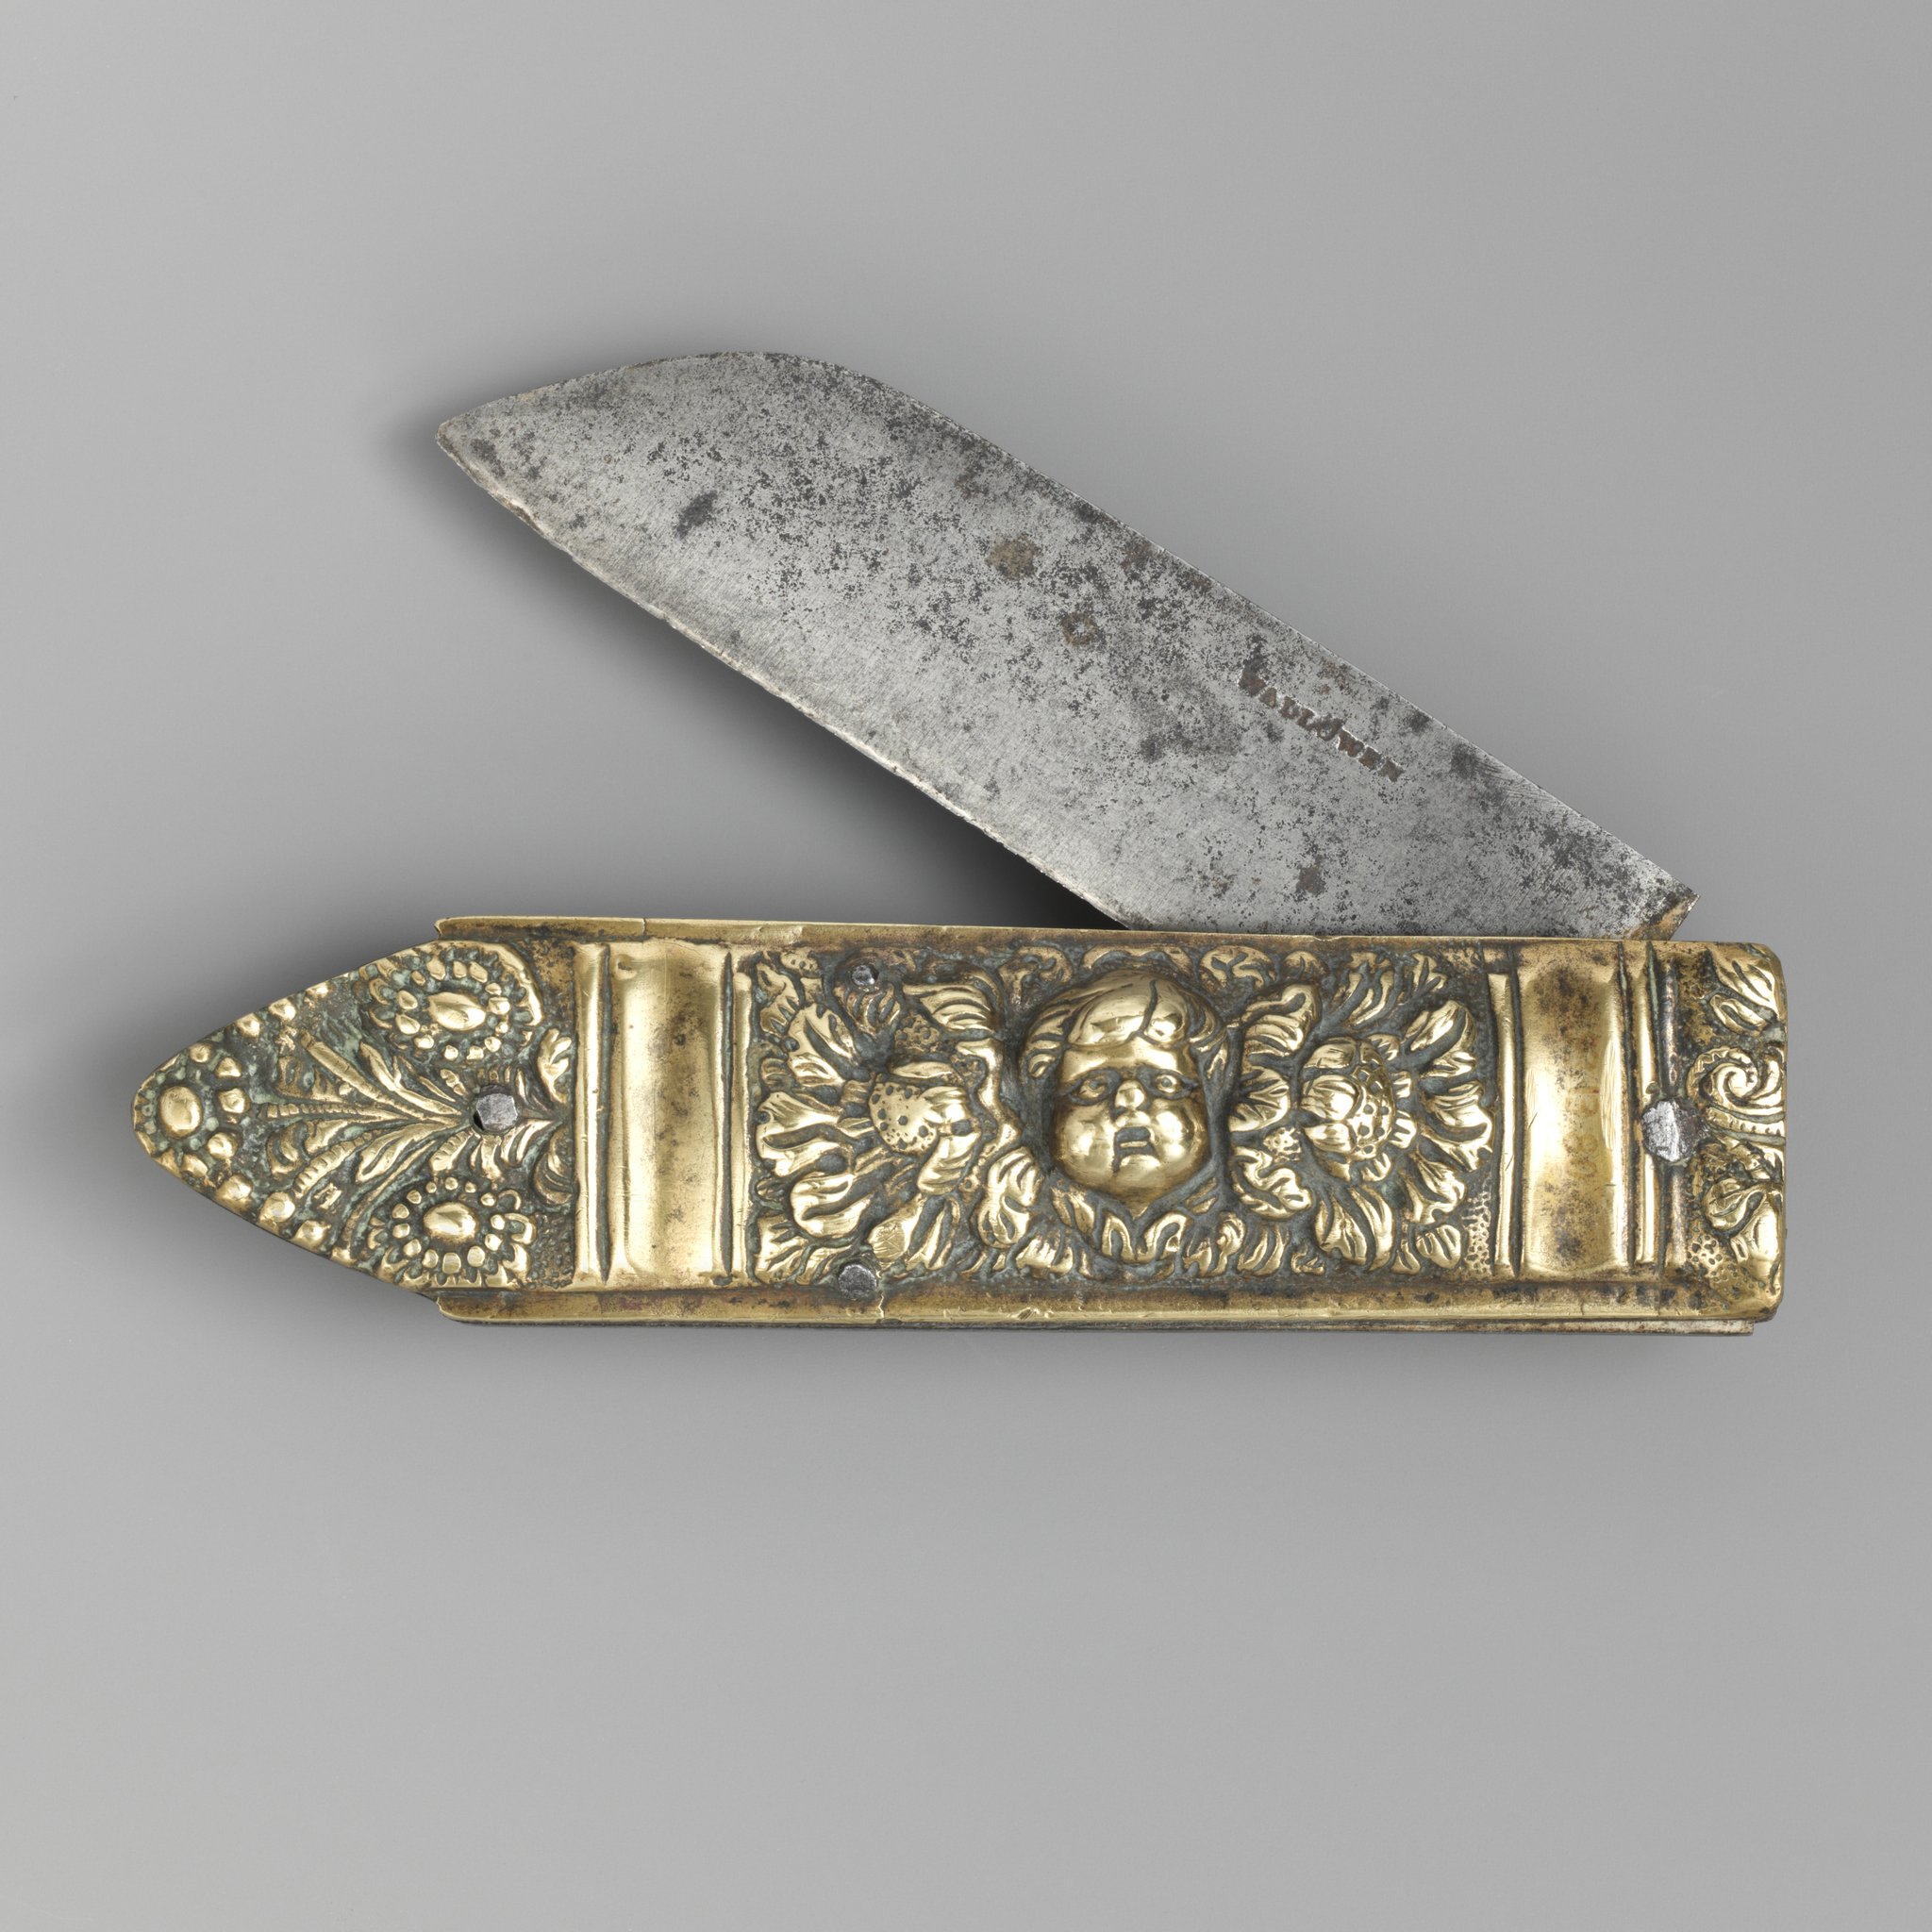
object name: clasp knife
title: Clasp knife with cherub's head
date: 1701-1733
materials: brass, steel